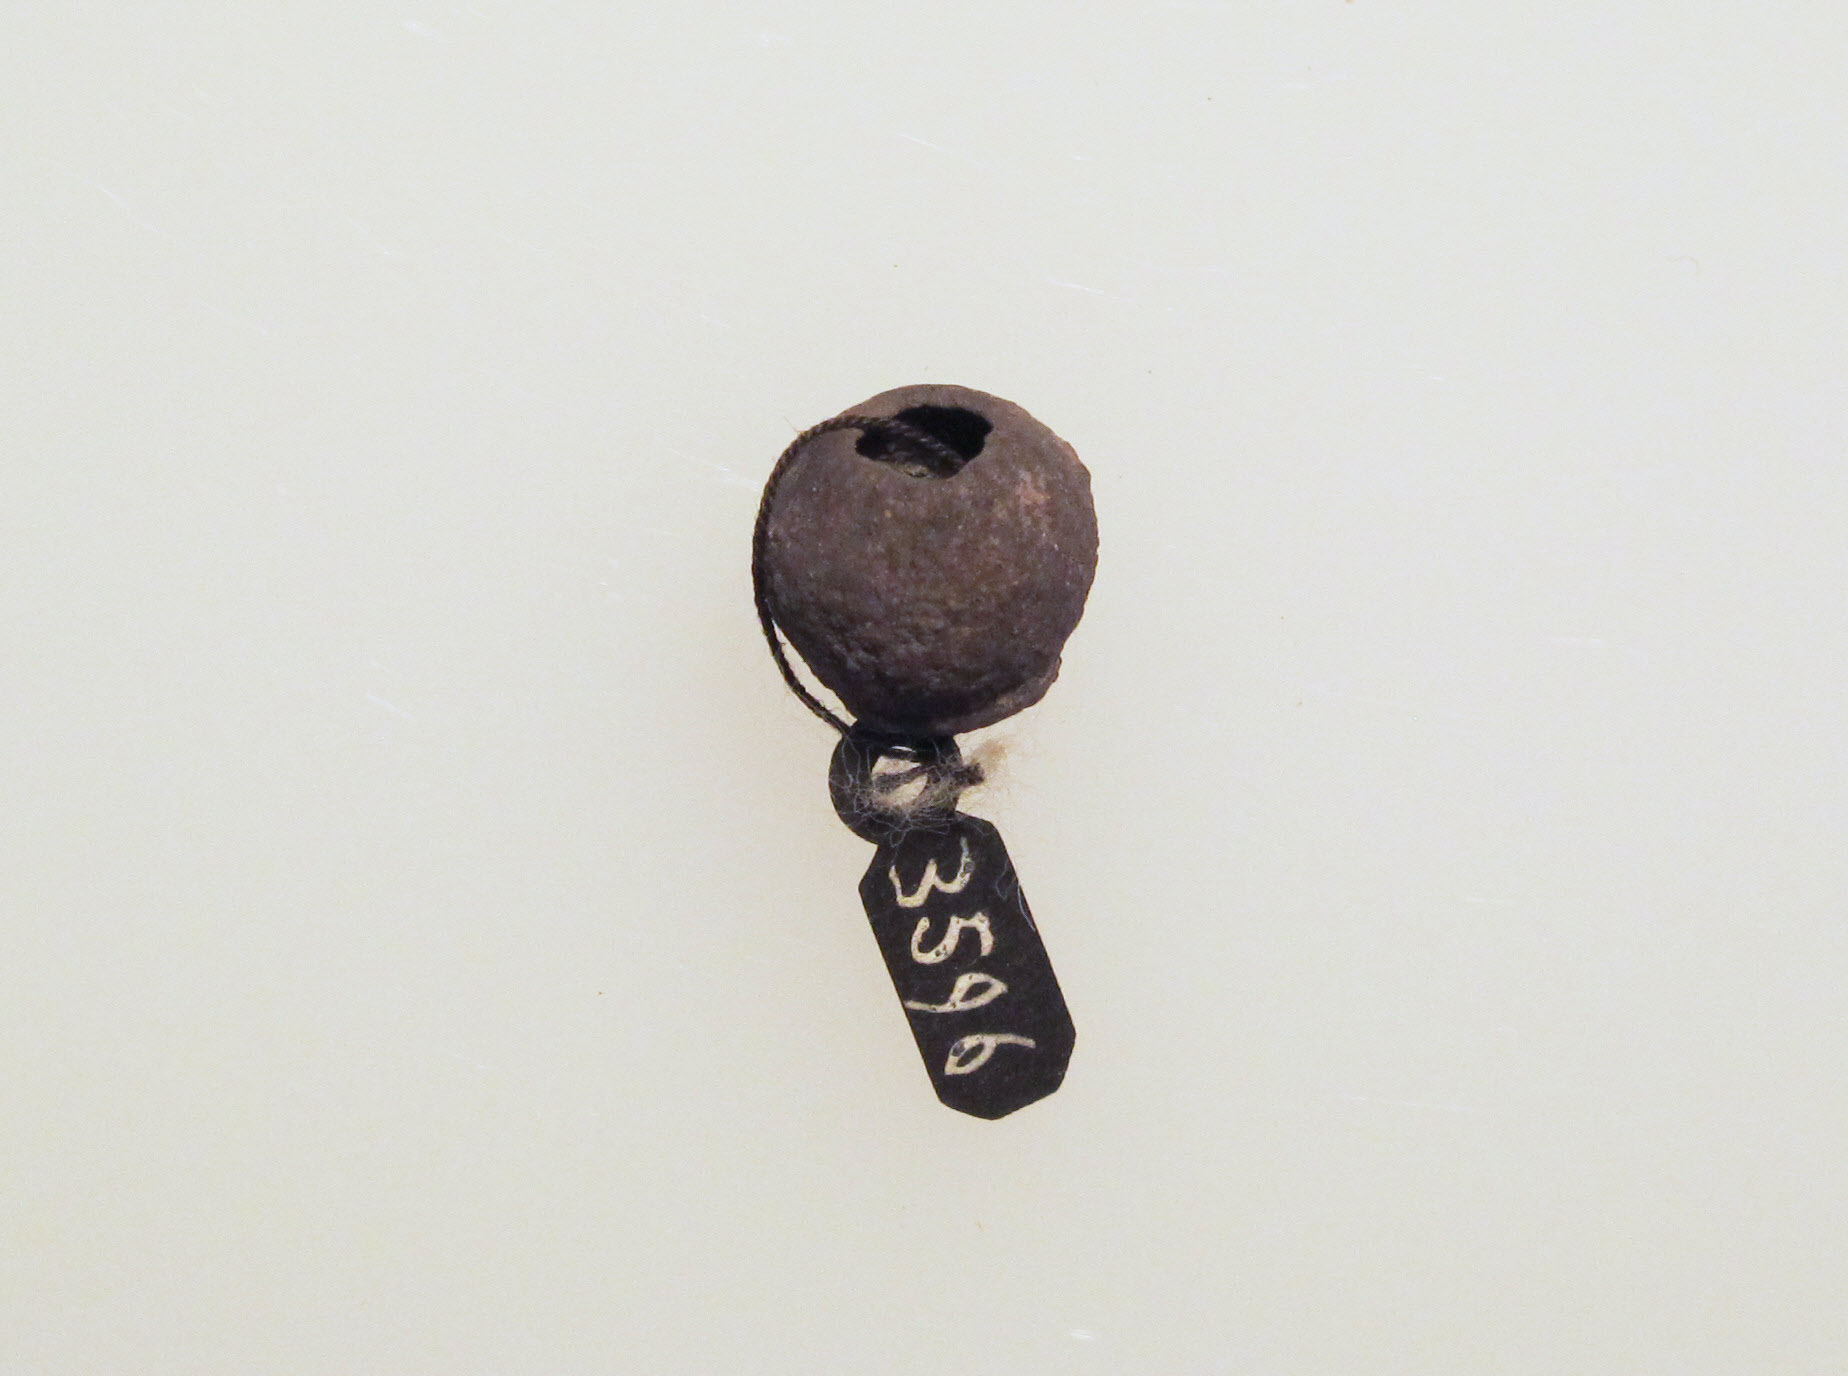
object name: bead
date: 7000 BCE-330 CE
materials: silver